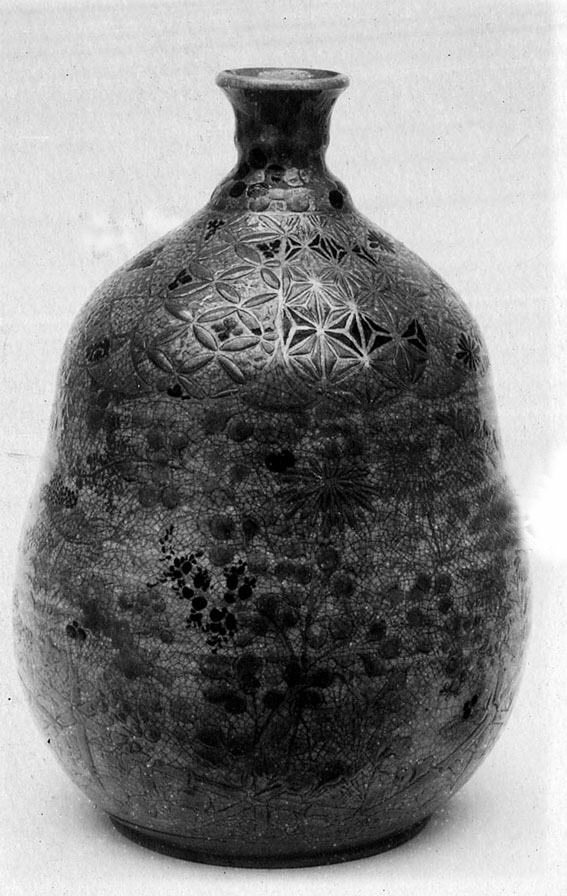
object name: wine bottle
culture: japanese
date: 1780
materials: clay, enamel, glaze, gold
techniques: polychrome